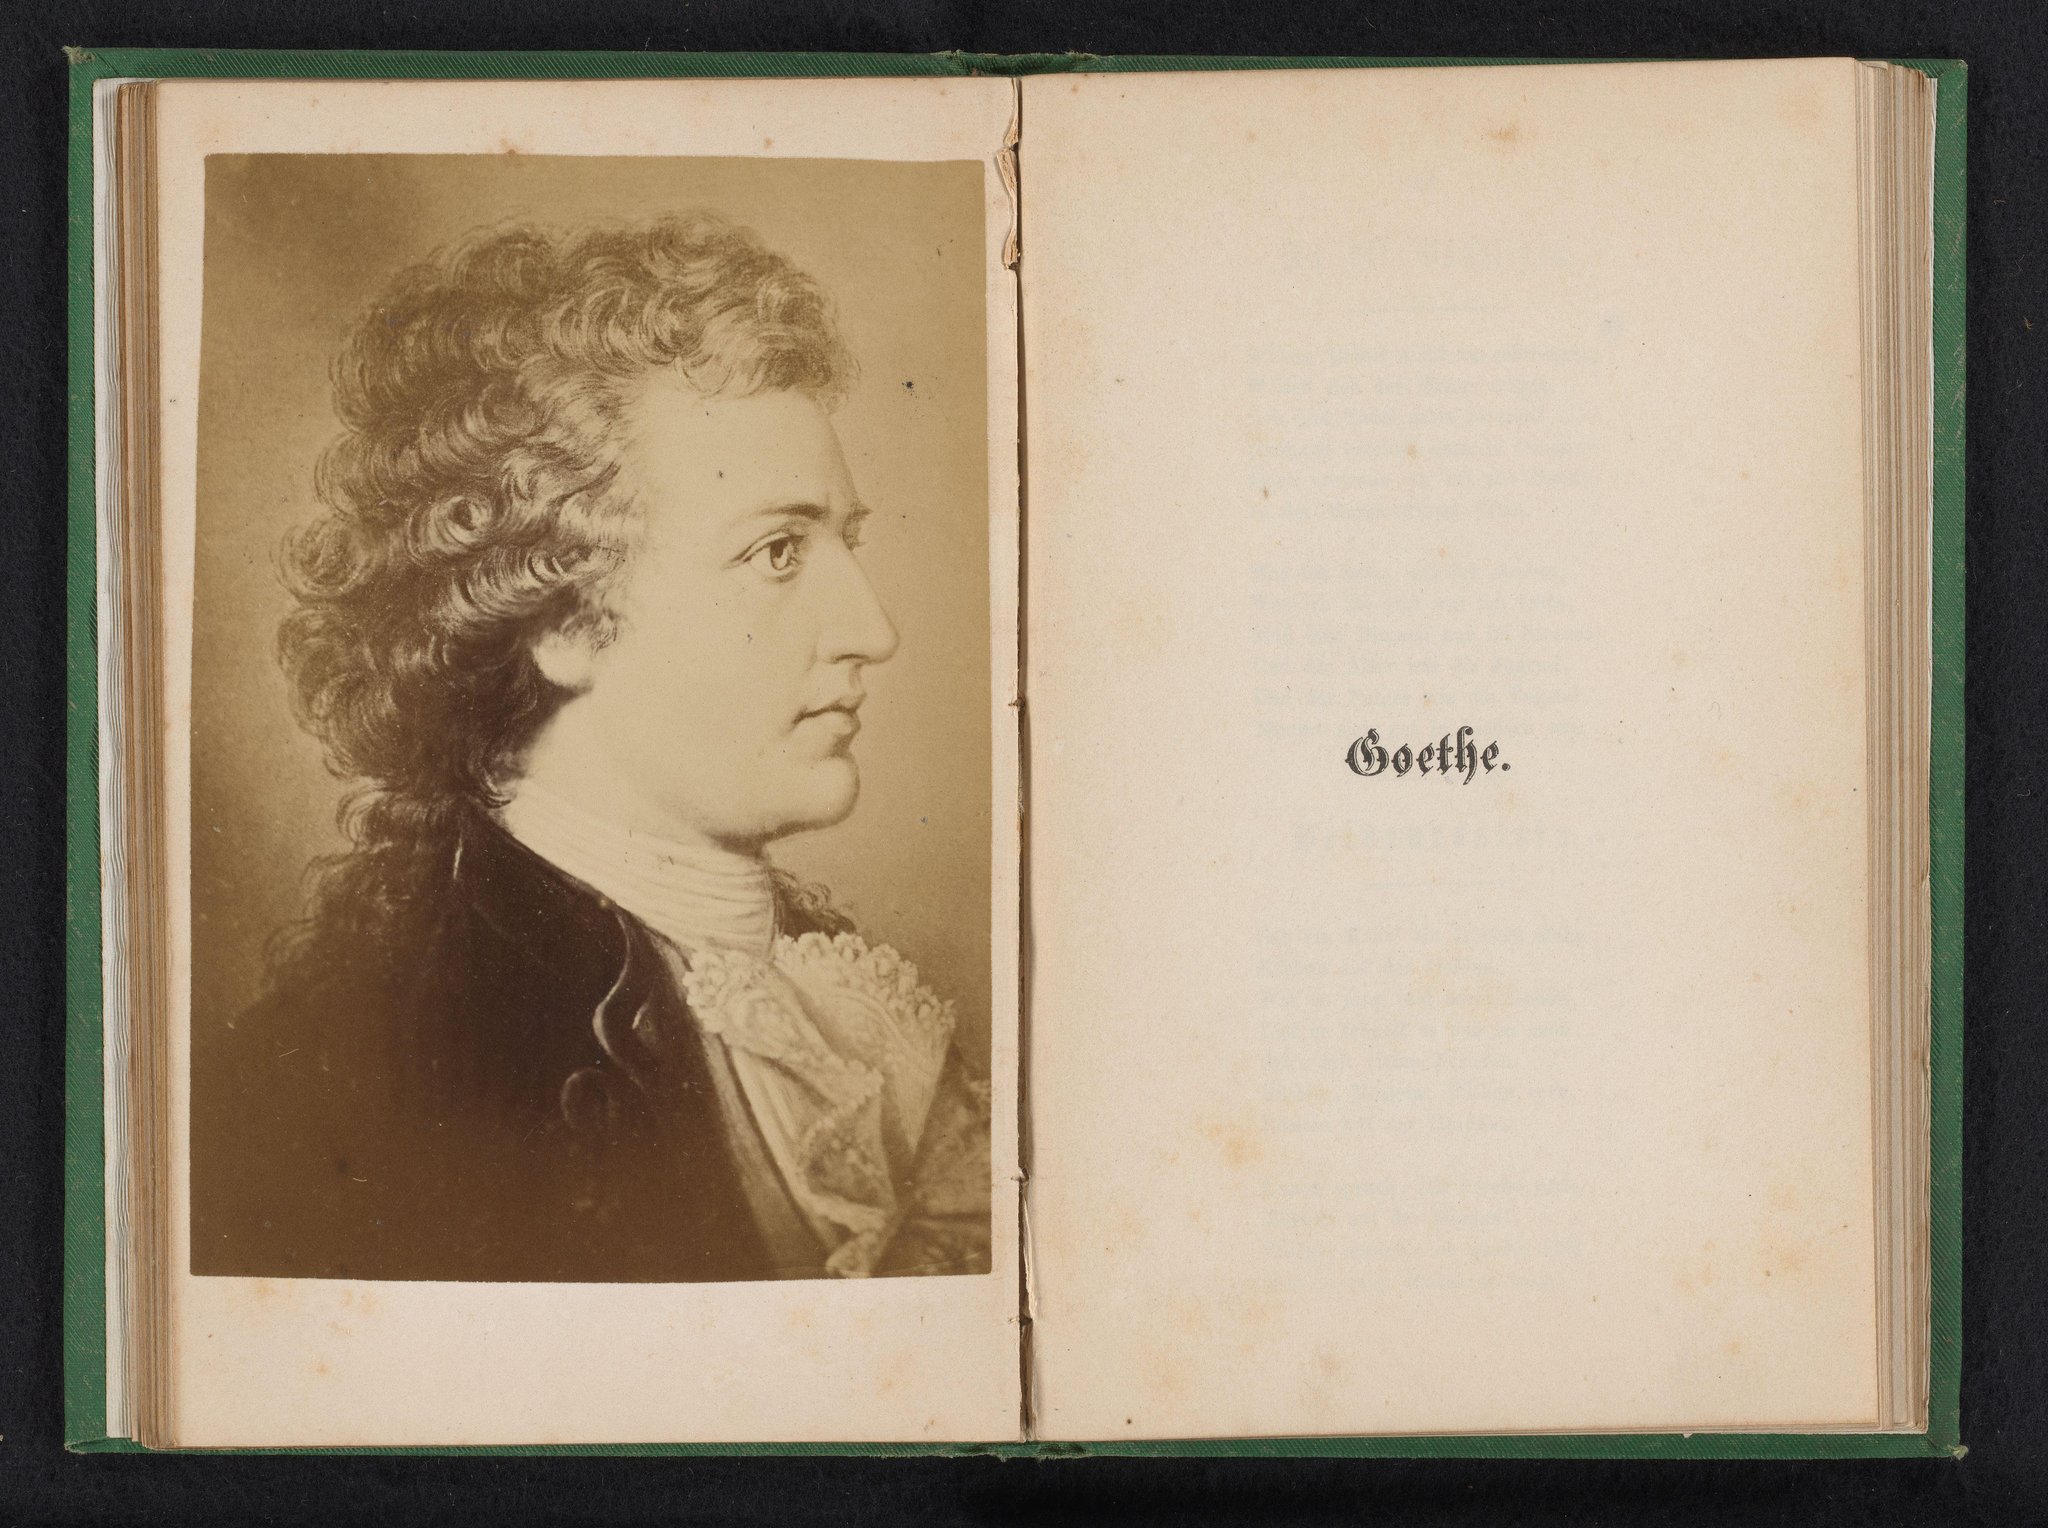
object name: reproduction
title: Fotoreproductie van een geschilderd portret van Johann Wolfgang von Goethe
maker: Anonymous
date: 1865-1875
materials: paper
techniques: albumen print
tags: draughtsman, johann wolfgang von goethe, portrait of a writer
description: Foto op eerste ongenummerde pagina na pagina 46.